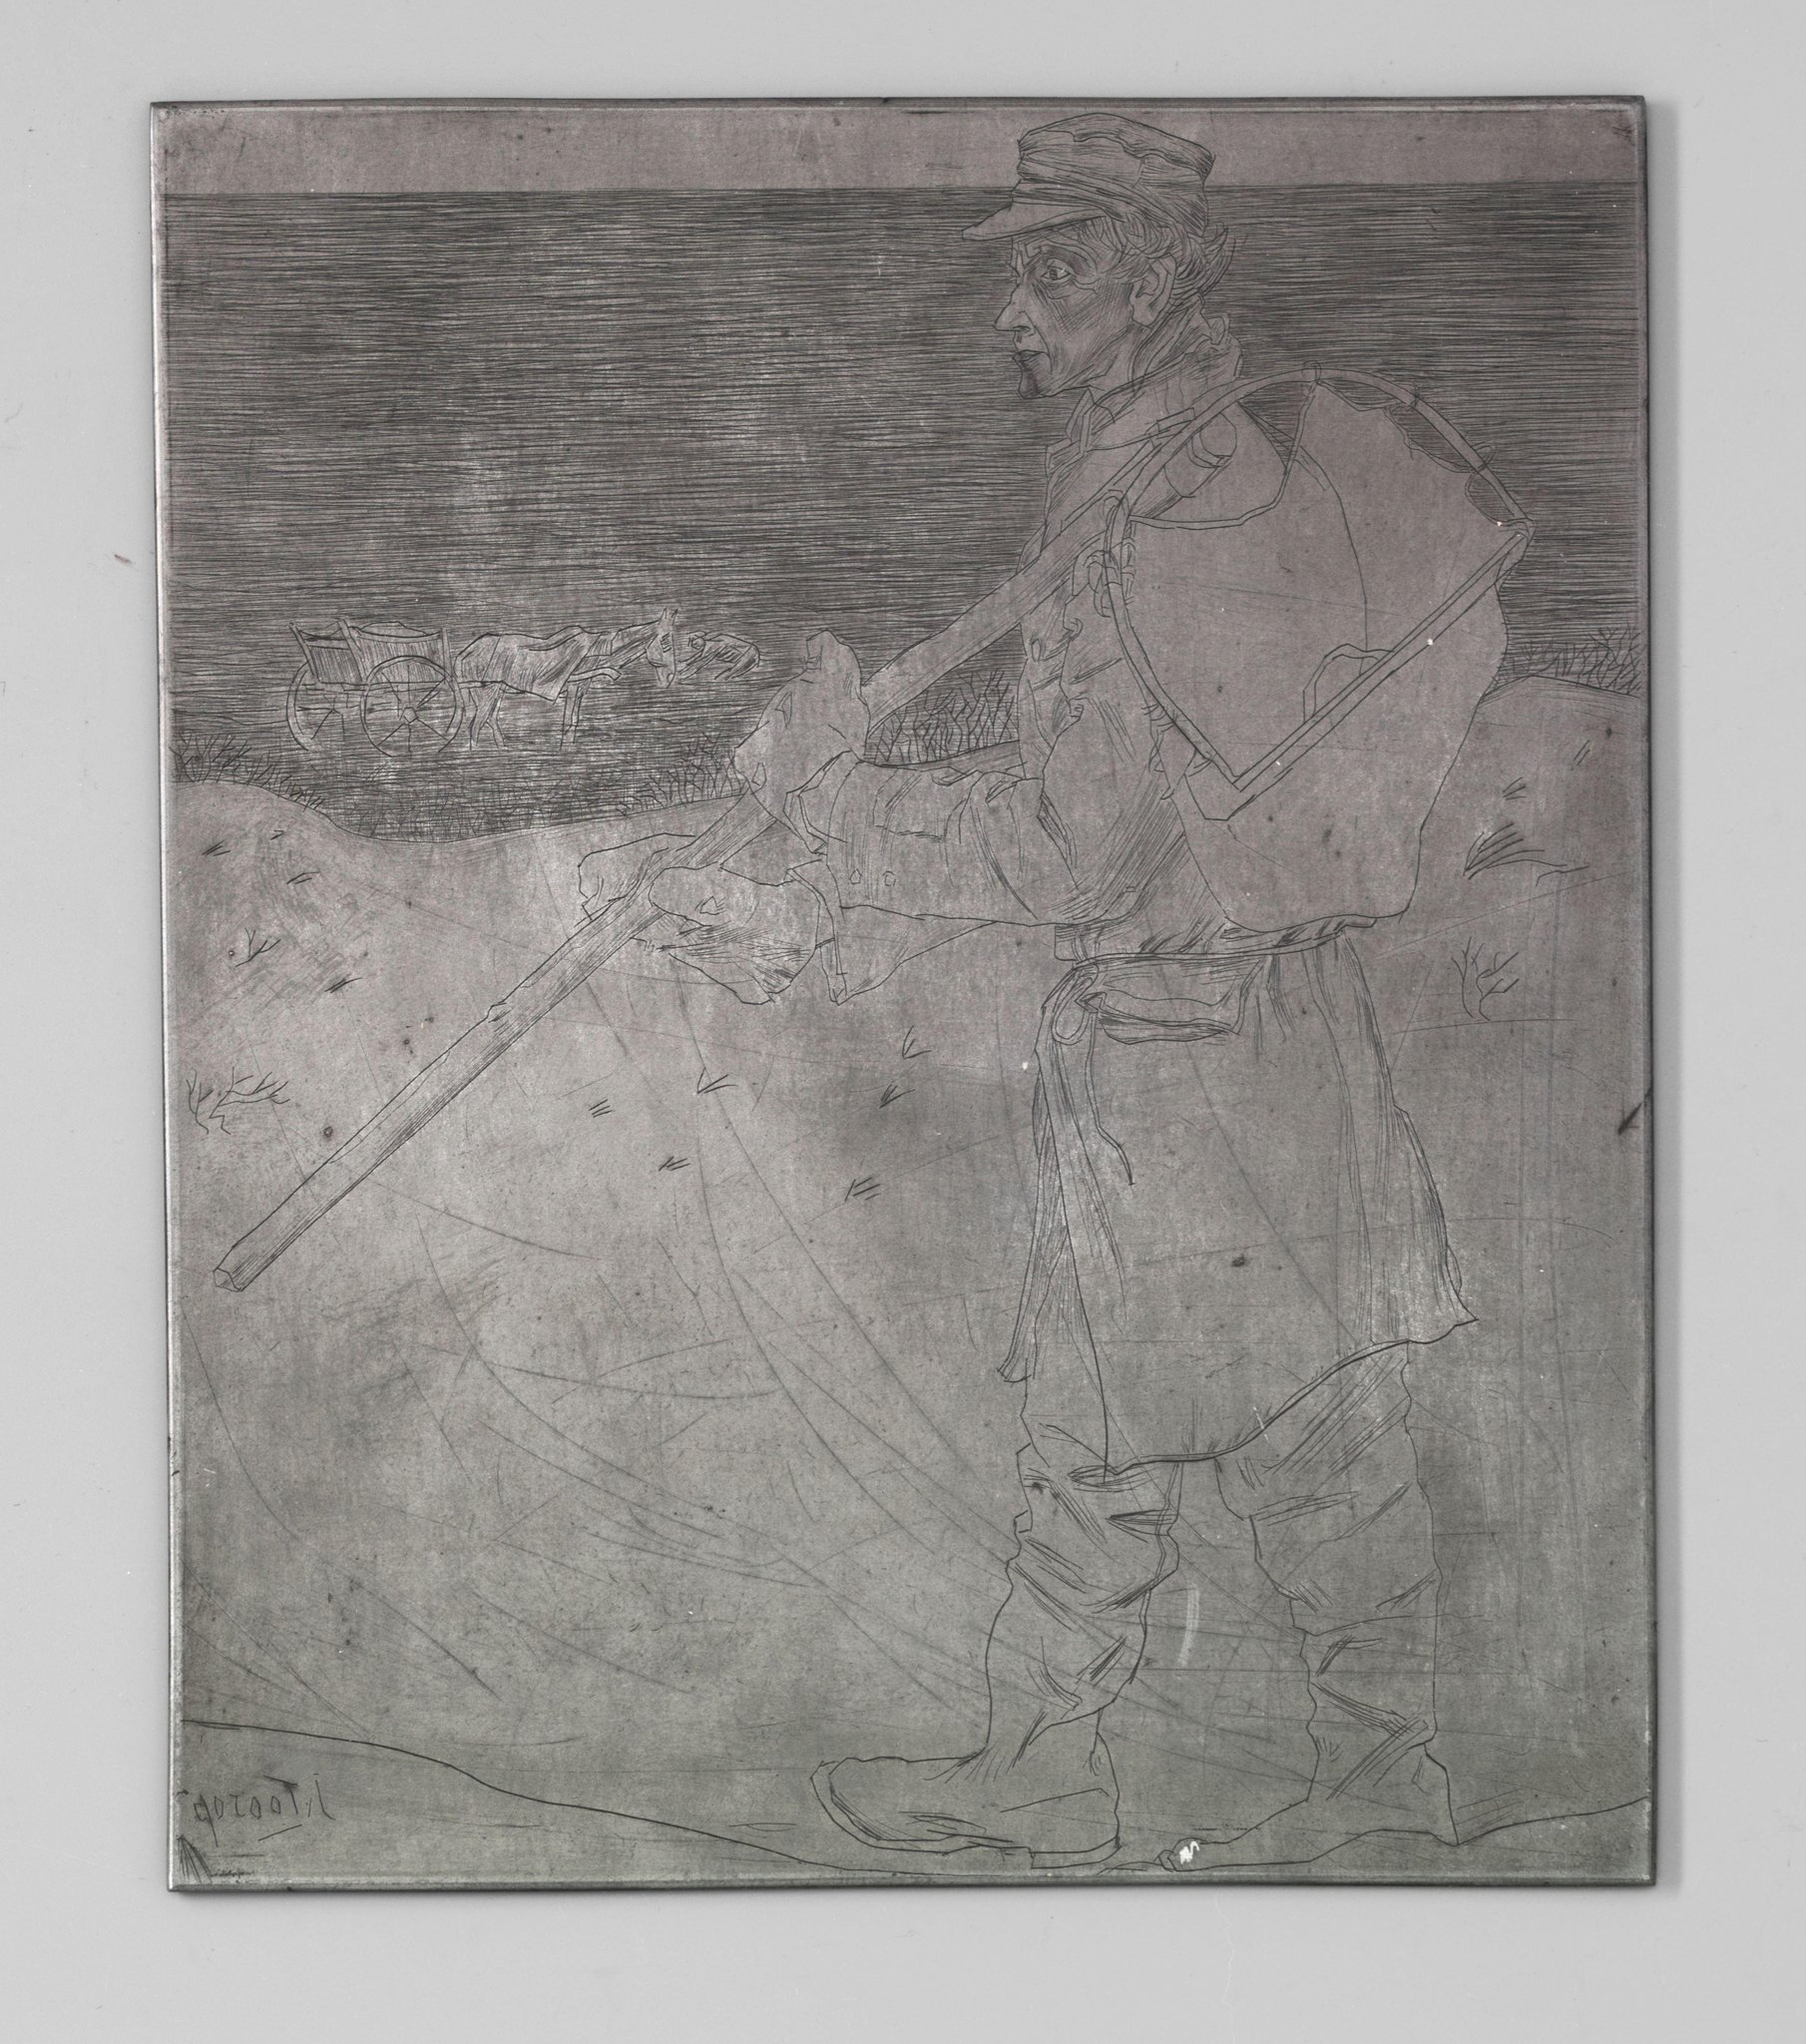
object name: zinkplaat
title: De schelpenvisser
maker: jan toorop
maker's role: draughtsman, painter, print maker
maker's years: 1858-1928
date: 1875-1928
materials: zinc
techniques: drypoint